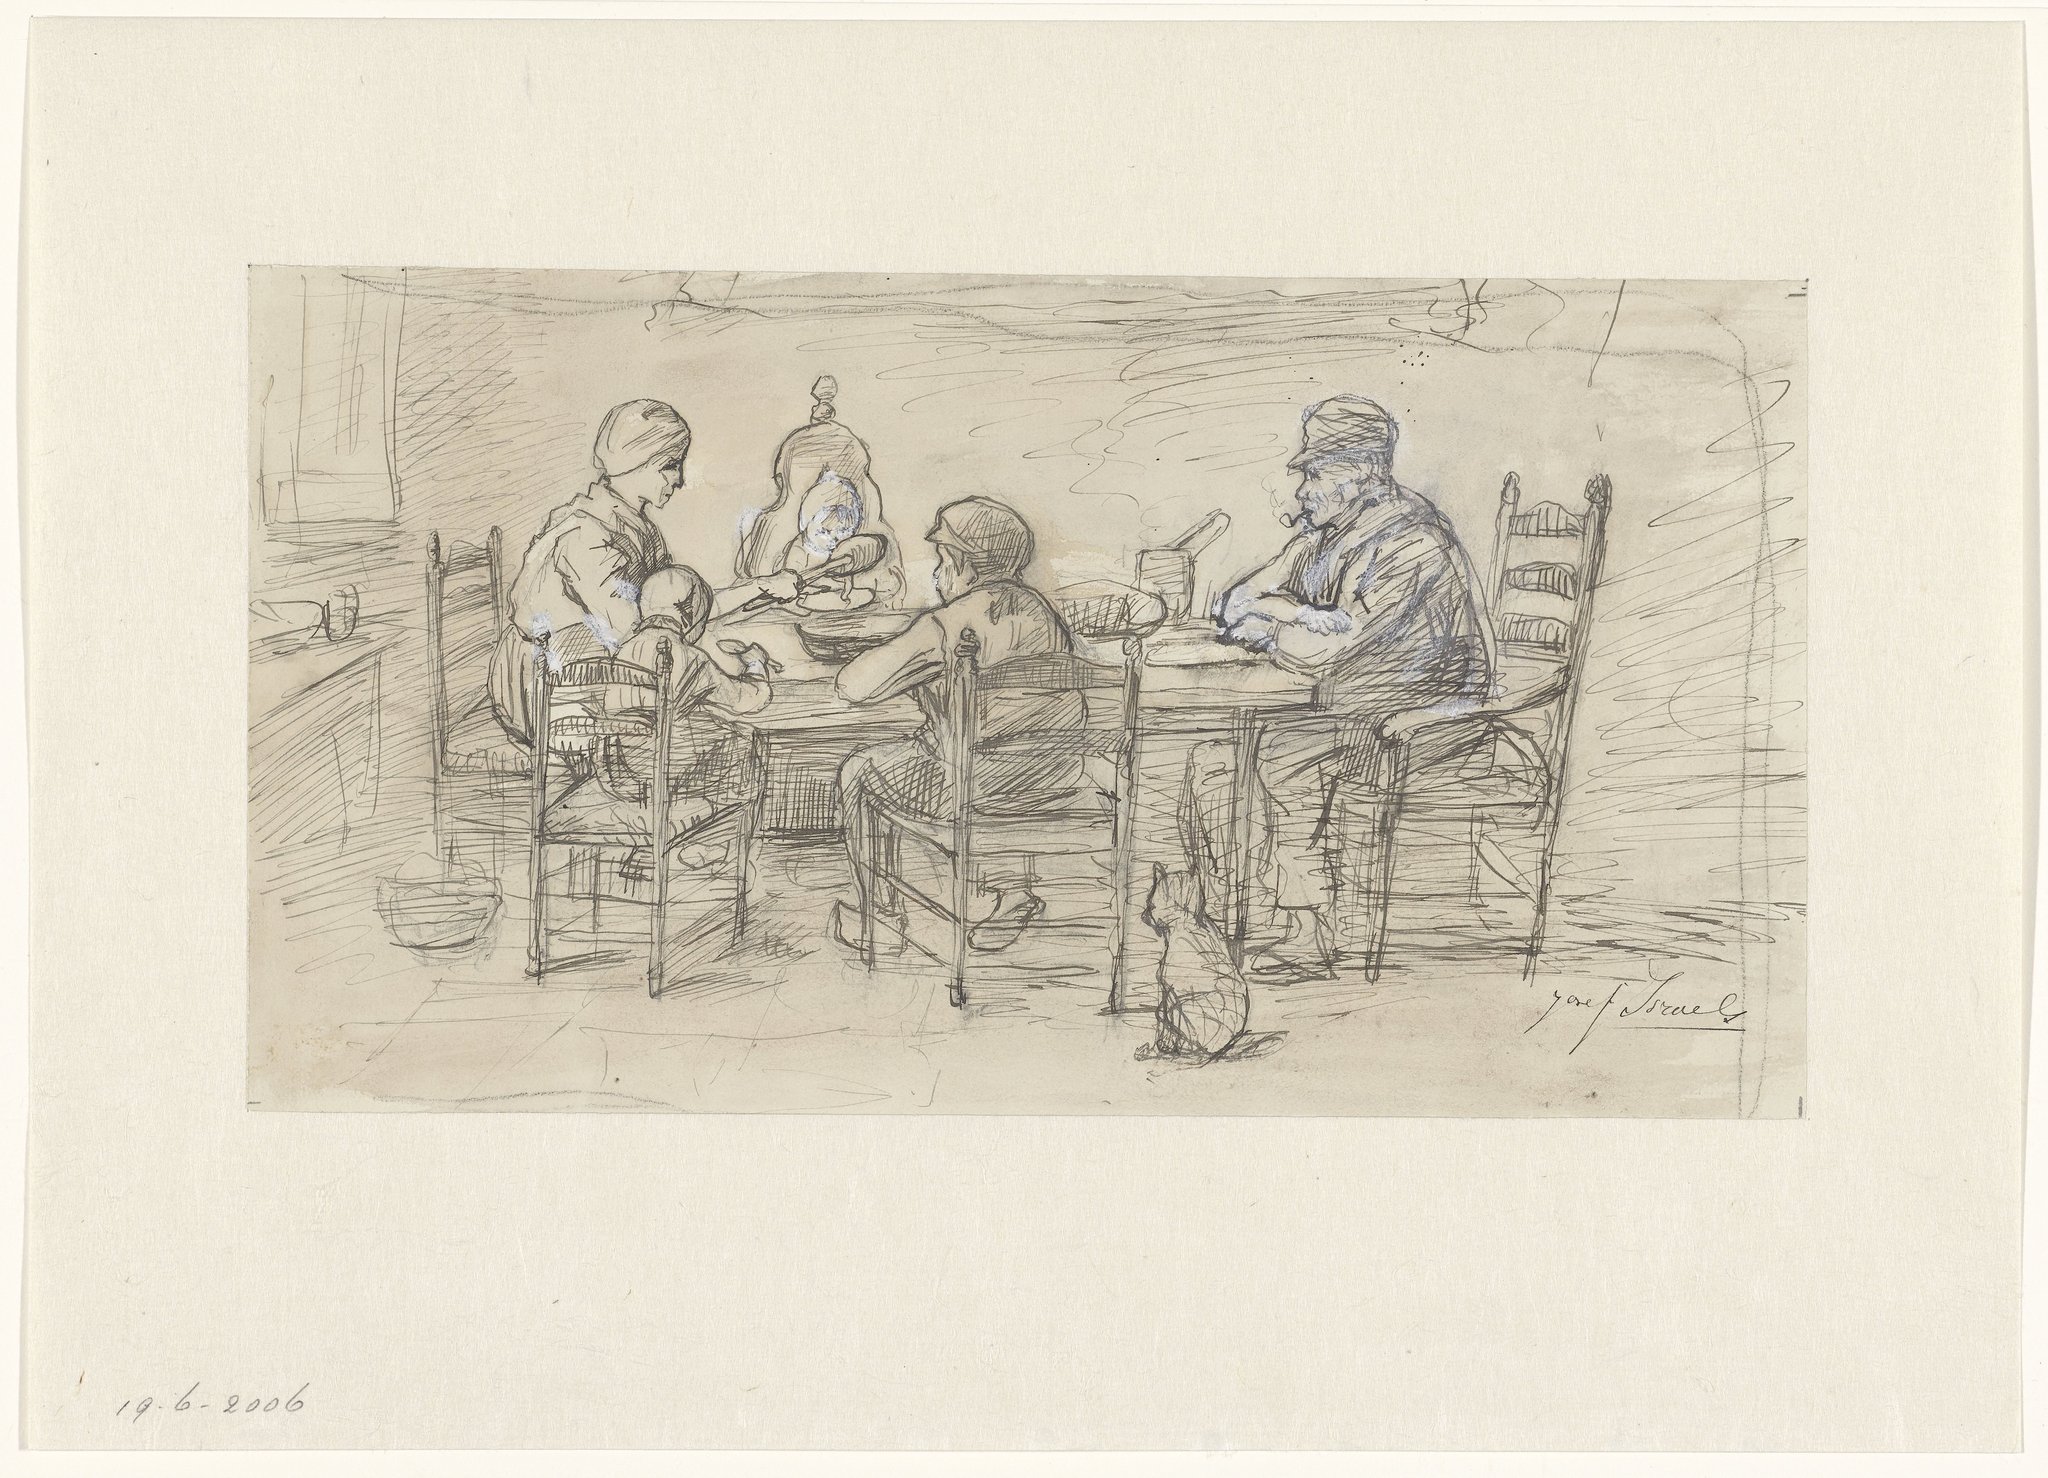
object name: drawing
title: Familie rond een tafel aan een maaltijd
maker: jozef israëls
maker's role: draughtsman, painter, print maker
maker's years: 1824-1911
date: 1834-1892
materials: paint, ink, paper, pencil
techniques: pen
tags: (family) meal